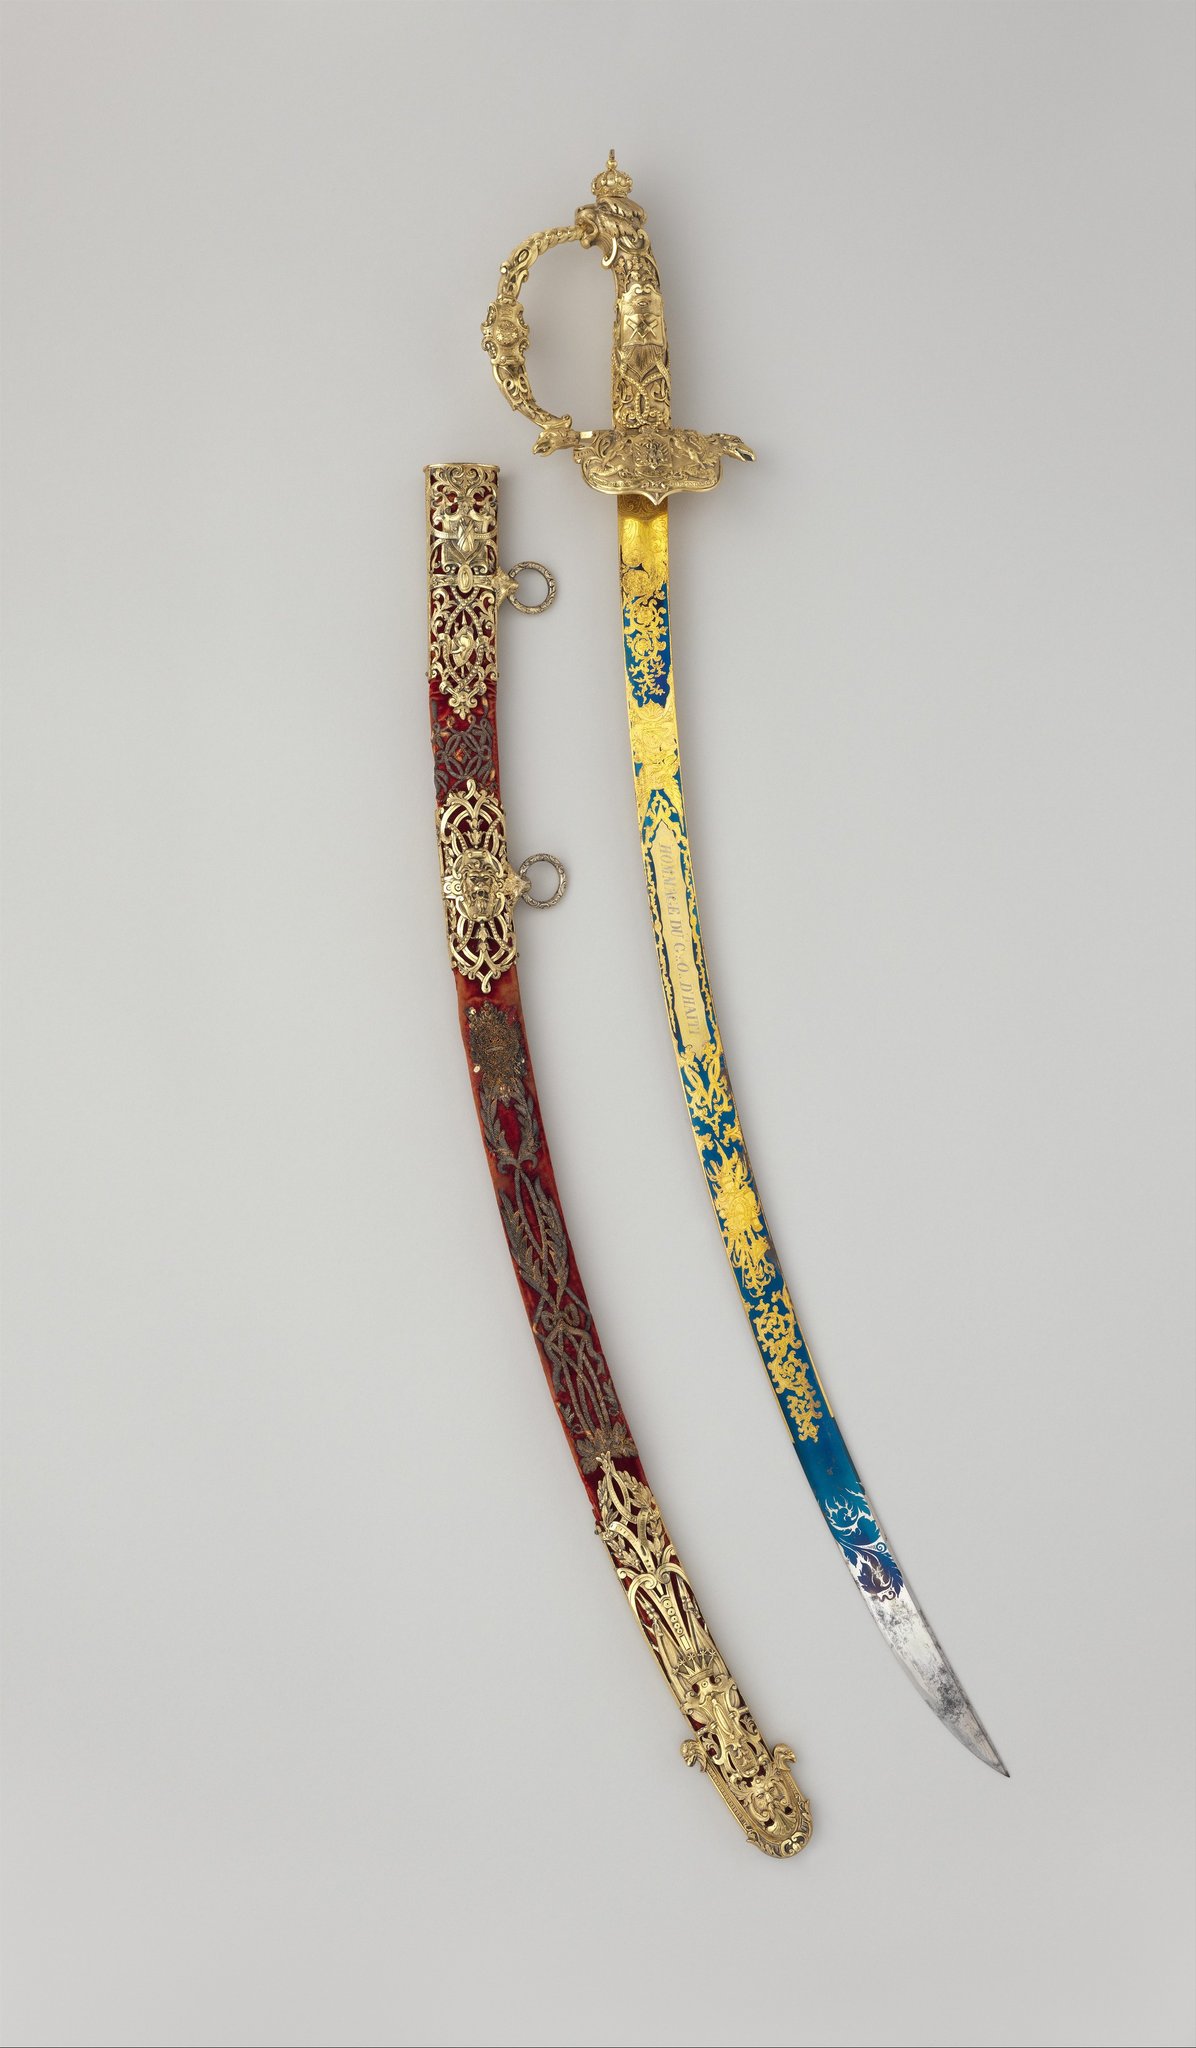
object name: sword with scabbard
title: Sword with Scabbard of Faustin I (1782–1867), Emperor of Haiti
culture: british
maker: robert mole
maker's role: sword cutler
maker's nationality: british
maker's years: 1800-1856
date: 1850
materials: gold, silver, steel, textile, wood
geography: england